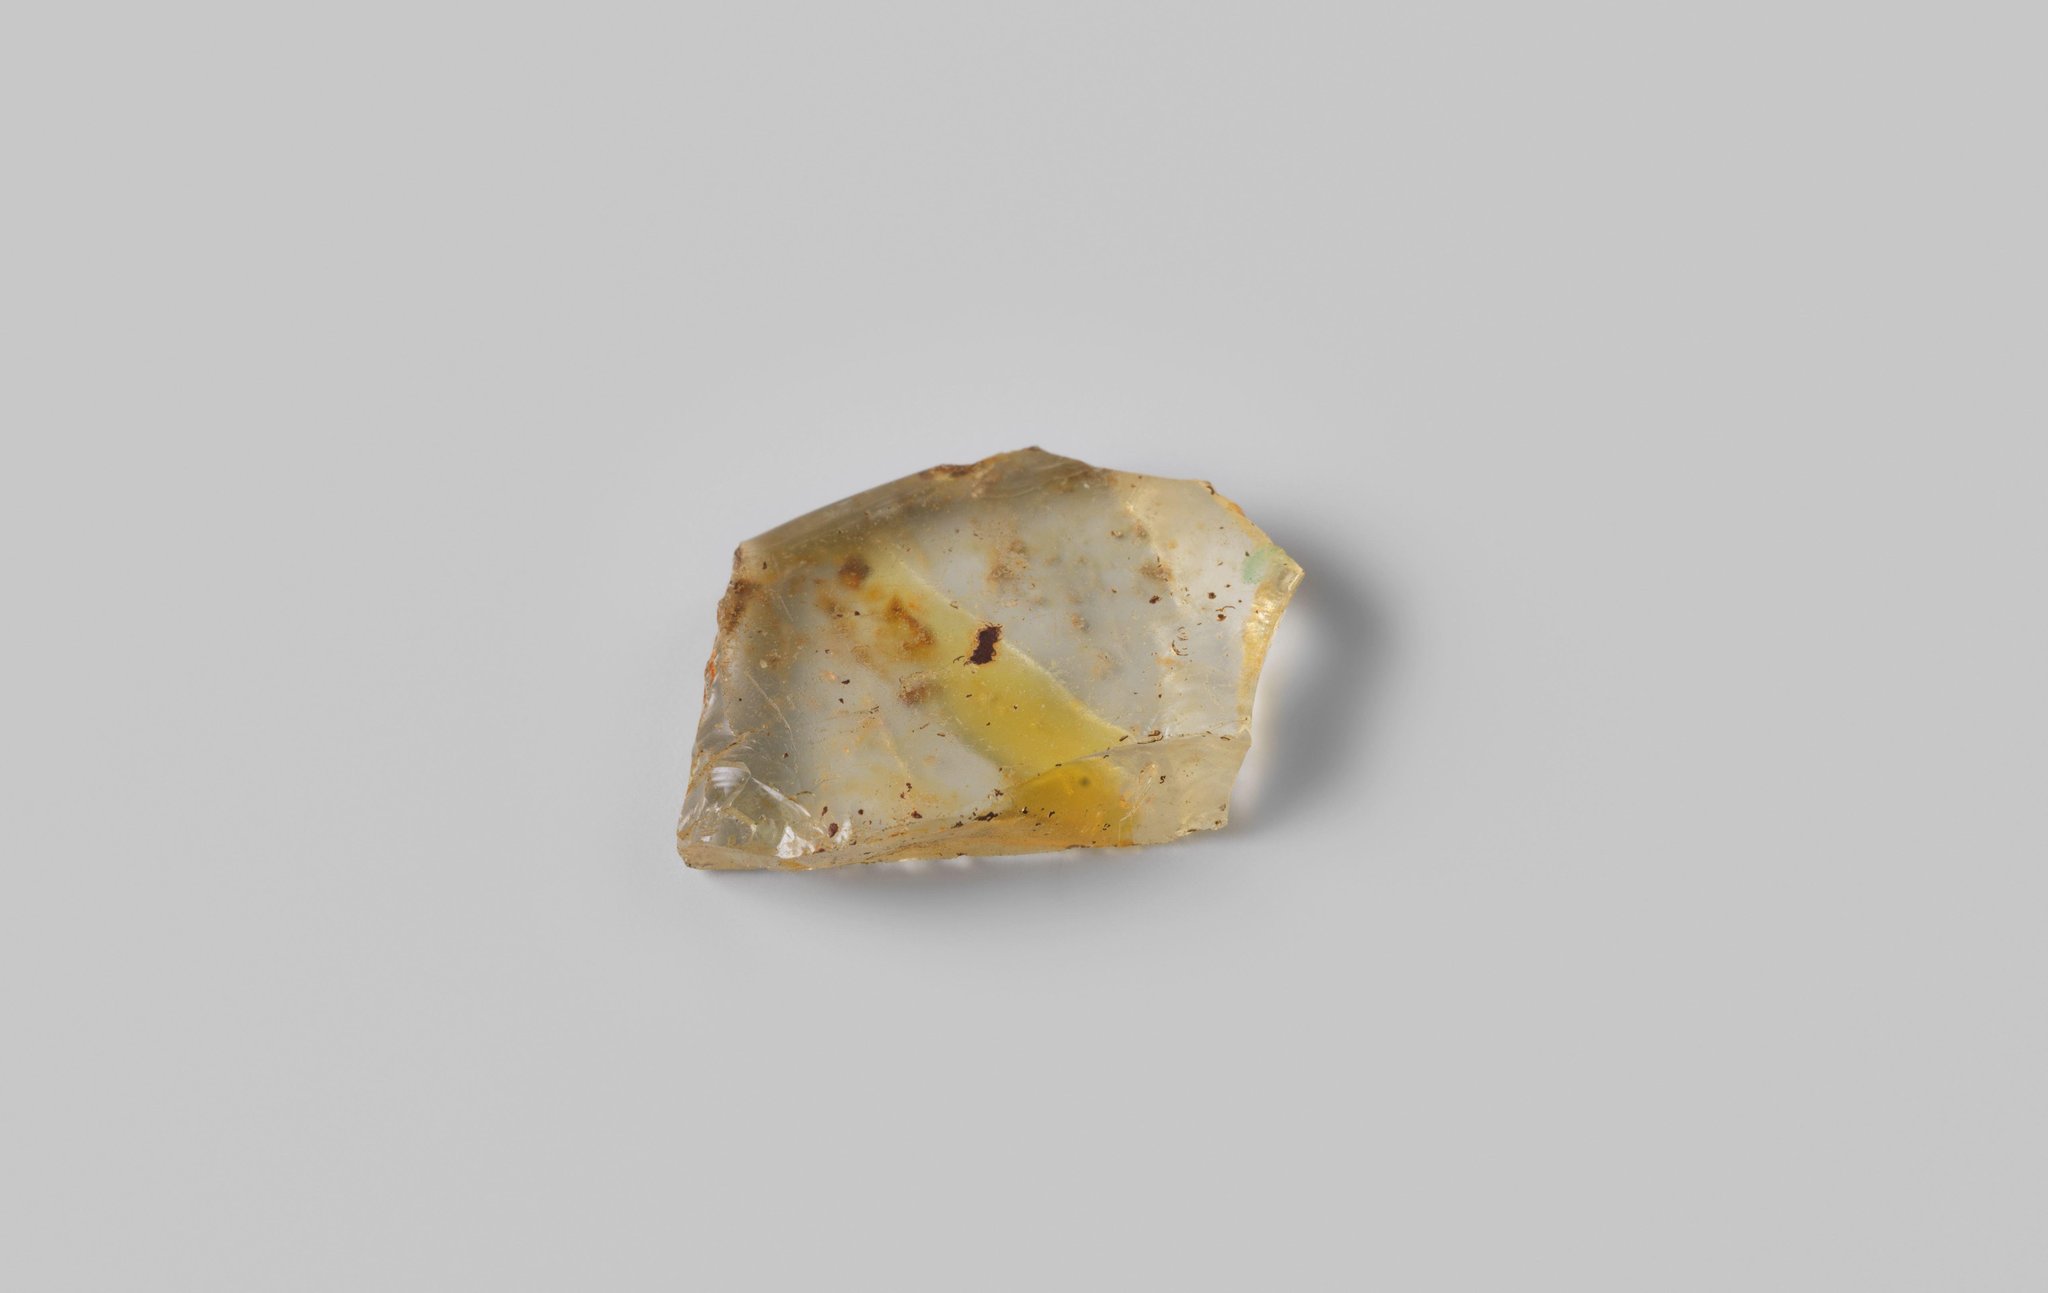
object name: light window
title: Fragment ruit uit het wrak van de Oost-Indiëvaarder Hollandia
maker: Anonymous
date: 1700-1743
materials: glass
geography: netherlands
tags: verenigde oostindische compagnie, hollandia (schip), annet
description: Varied parts or fragments, window glass; fragm, broken, flat.